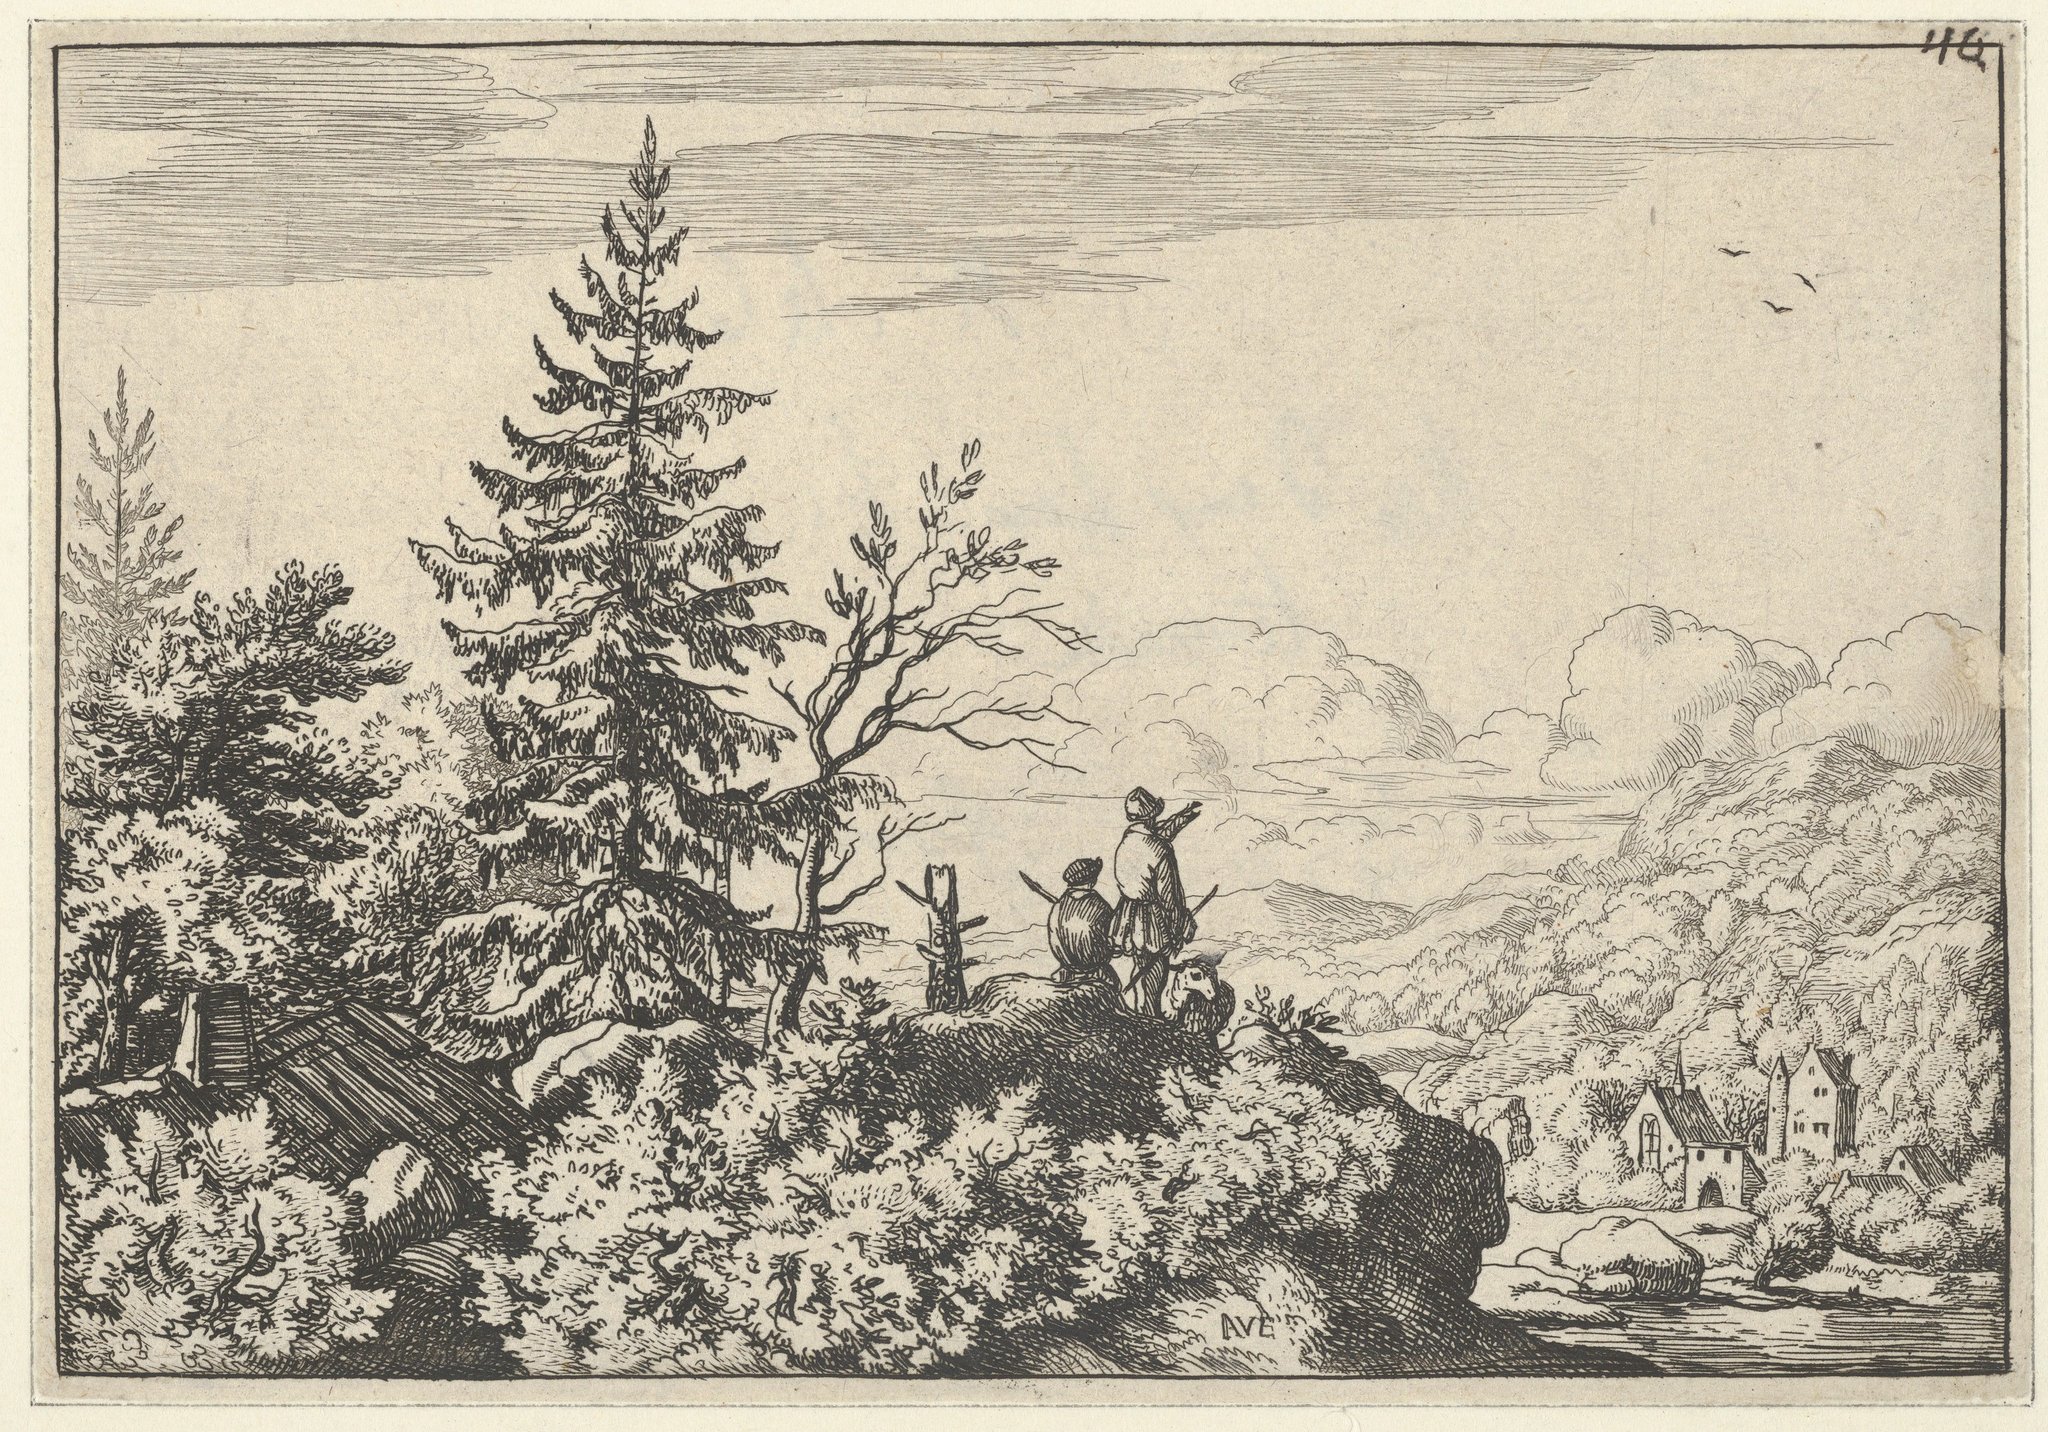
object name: print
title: The Two Men on the Hill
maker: allart van everdingen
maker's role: artist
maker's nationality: dutch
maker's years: 1621-1675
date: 1621-1675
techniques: engraving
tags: men,hills,landscapes,trees